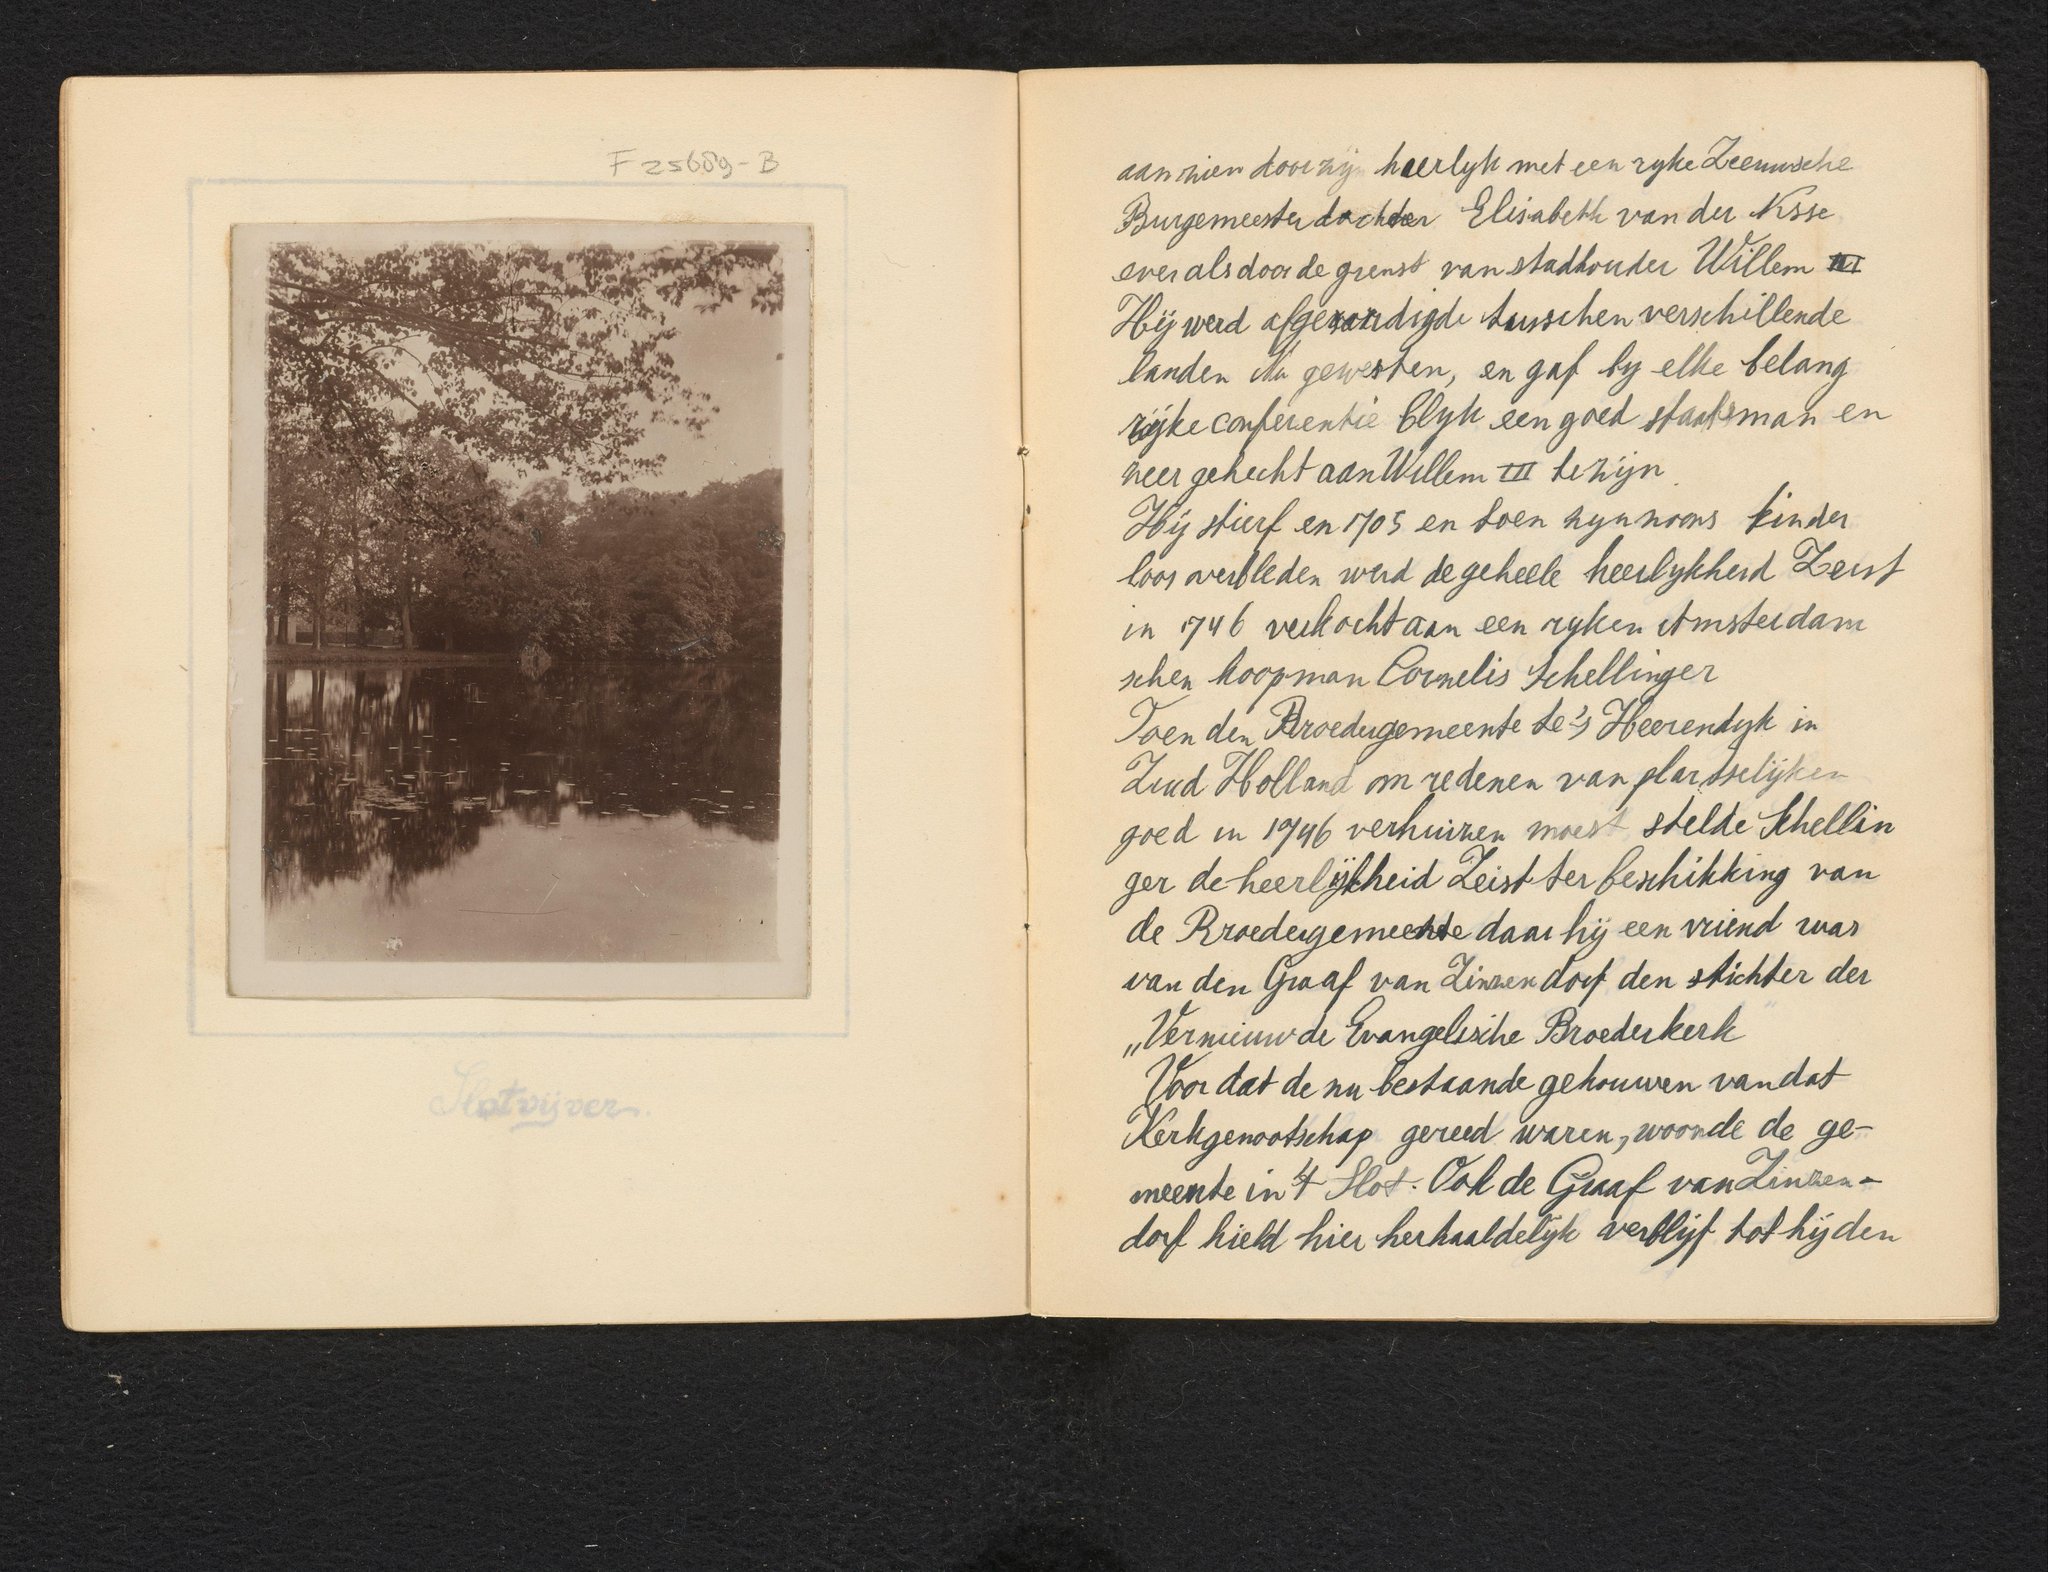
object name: page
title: Vijver bij Slot Zeist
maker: Anonymous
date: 1911-1916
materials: paper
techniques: gelatin silver print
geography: zeist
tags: pond, pool